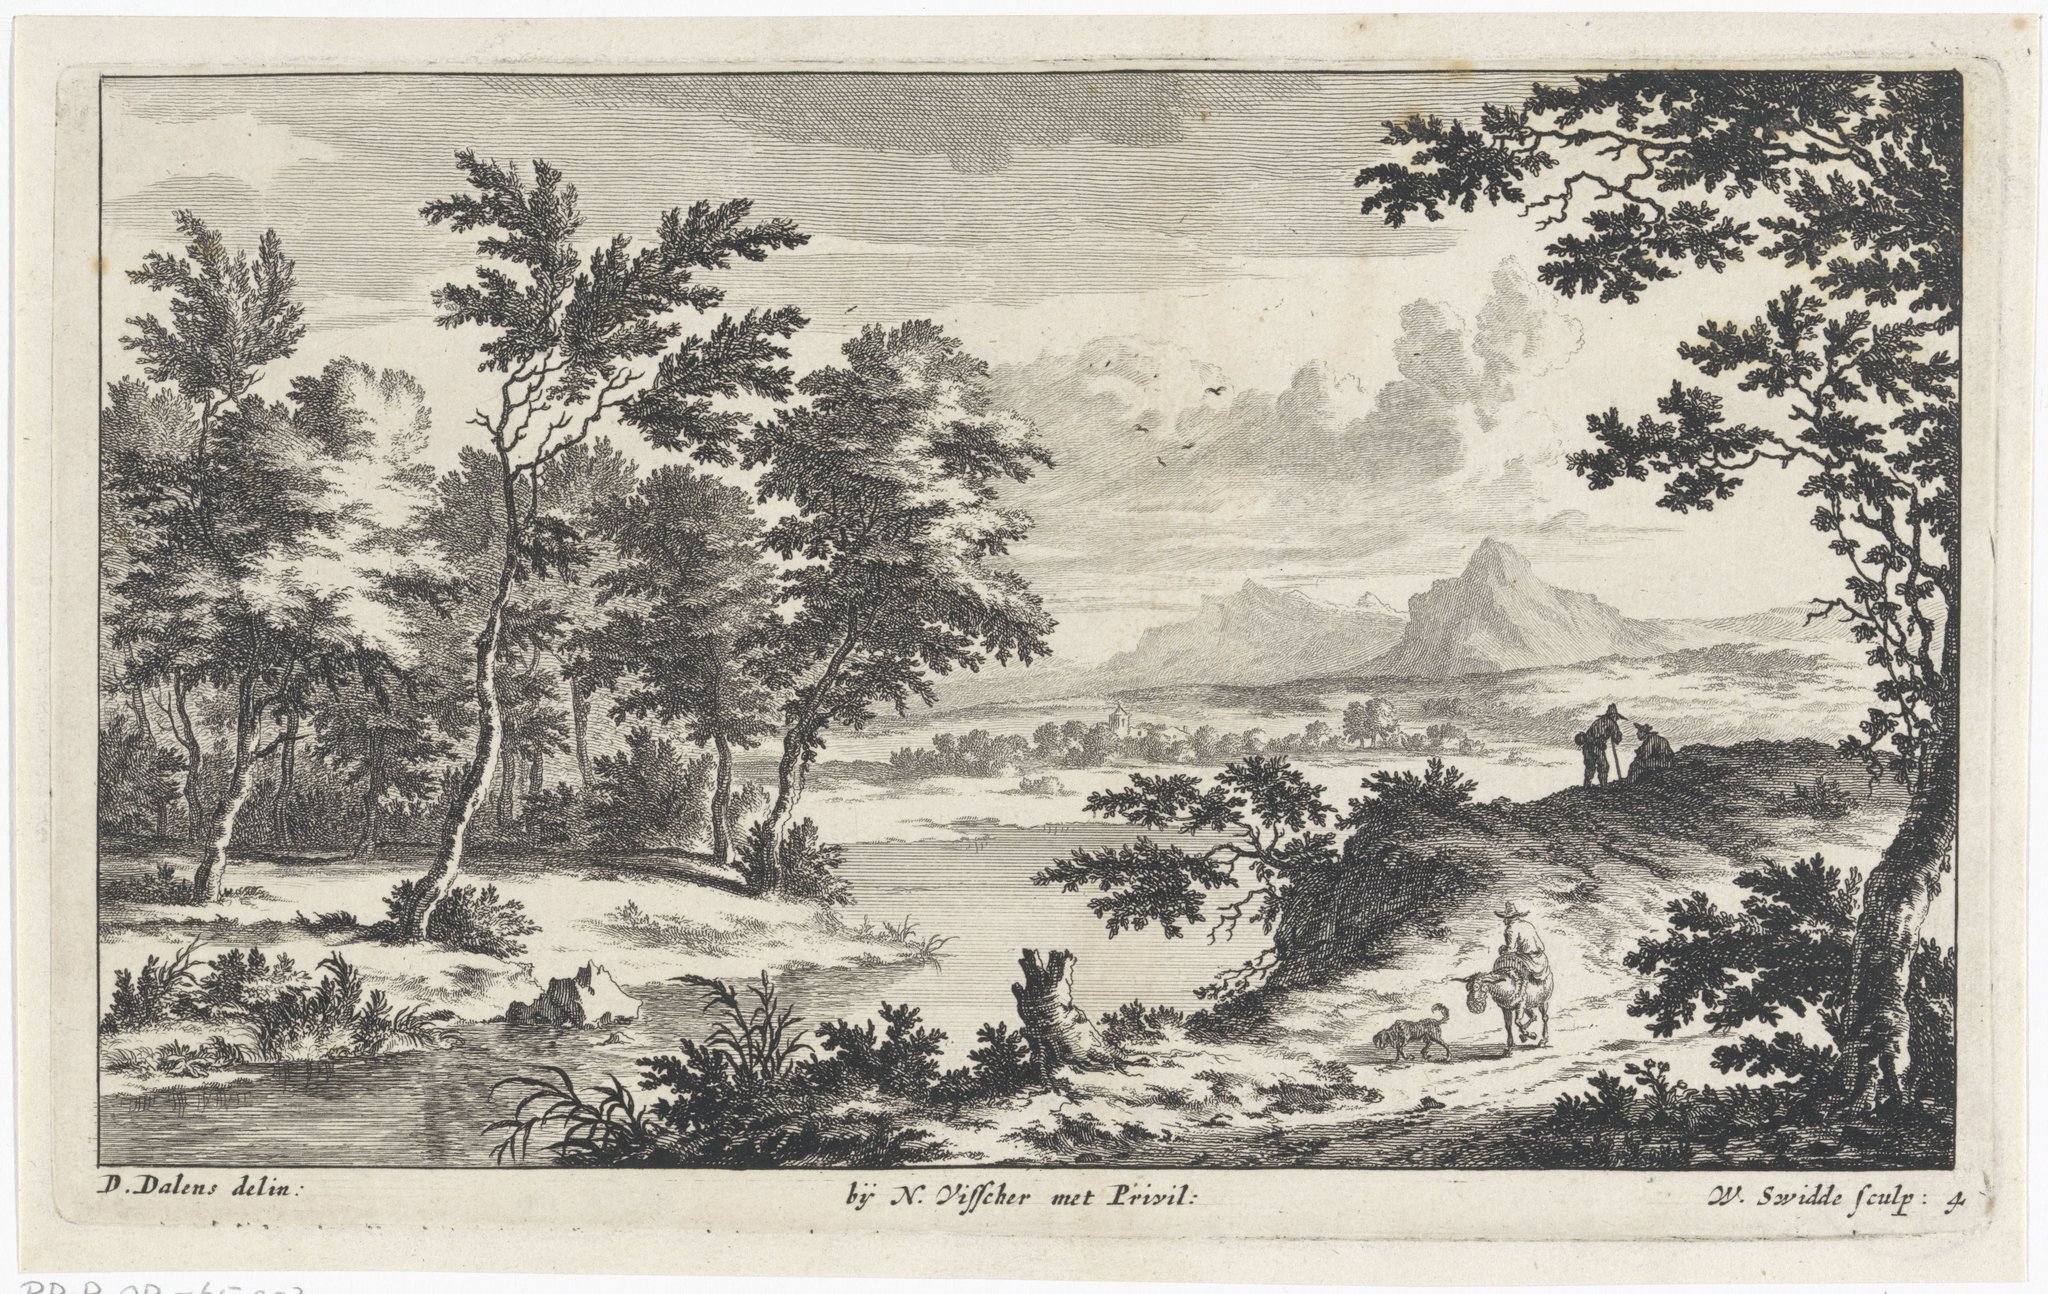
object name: print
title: Landschap met man op ezel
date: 1676-1688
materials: paper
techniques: etching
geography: amsterdam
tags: river bank - hh - ideal landscapes, ass, donkey, dog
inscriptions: collector's mark: Lugt 240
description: Op een beboste oever van een rivier rijdt een man op een ezel. Zijn hond loopt voor hem uit. Op de achtergrond twee pratende mannen.